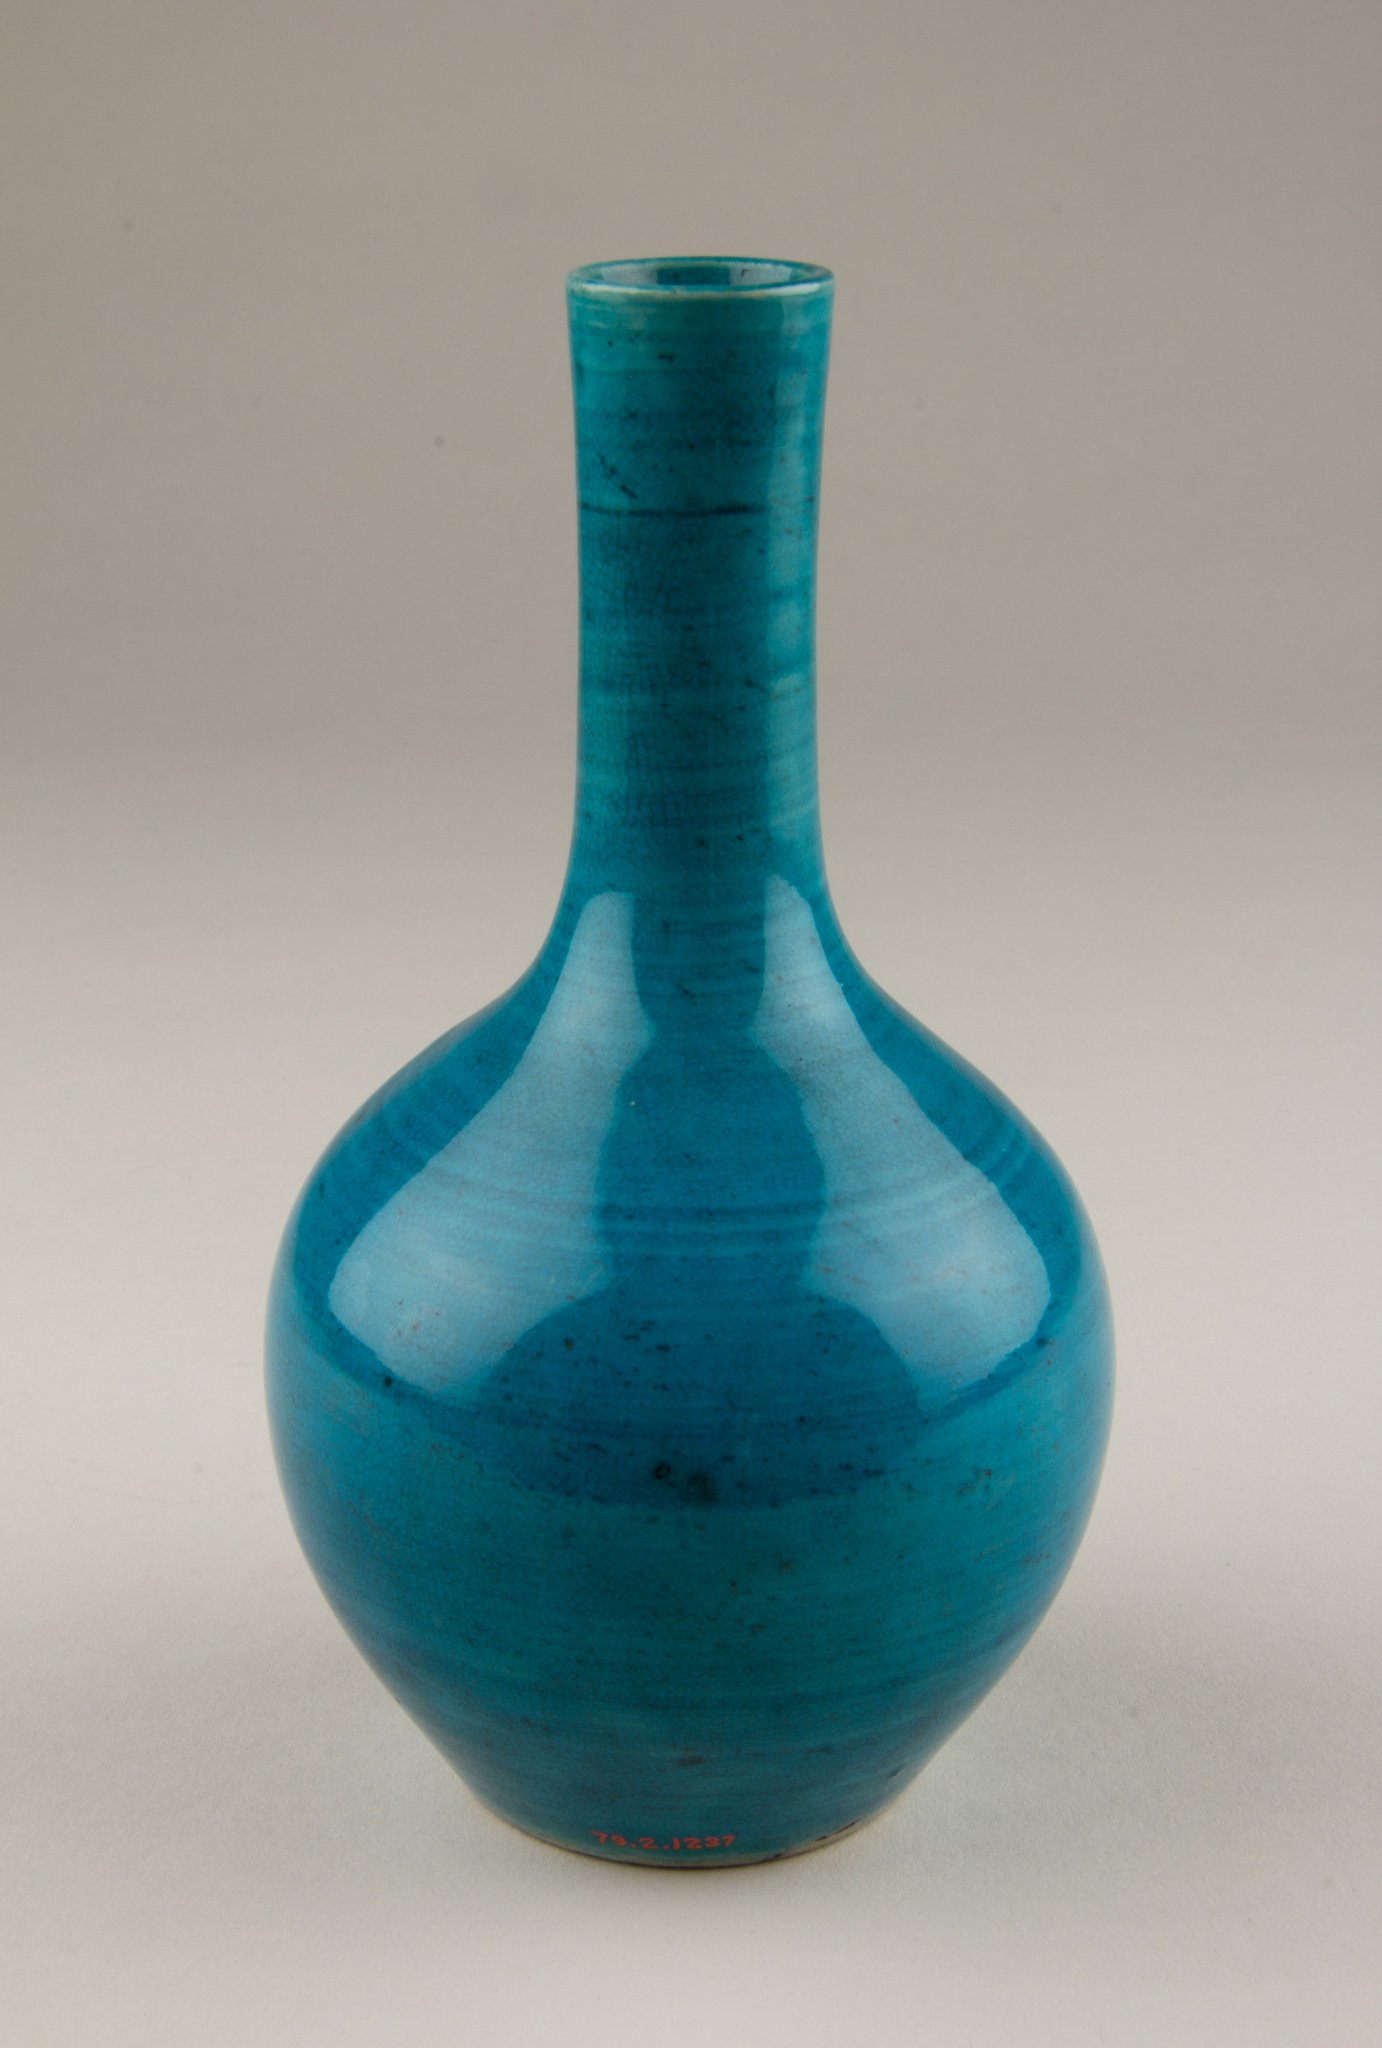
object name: vase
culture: chinese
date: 1801-1850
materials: glaze, porcelain